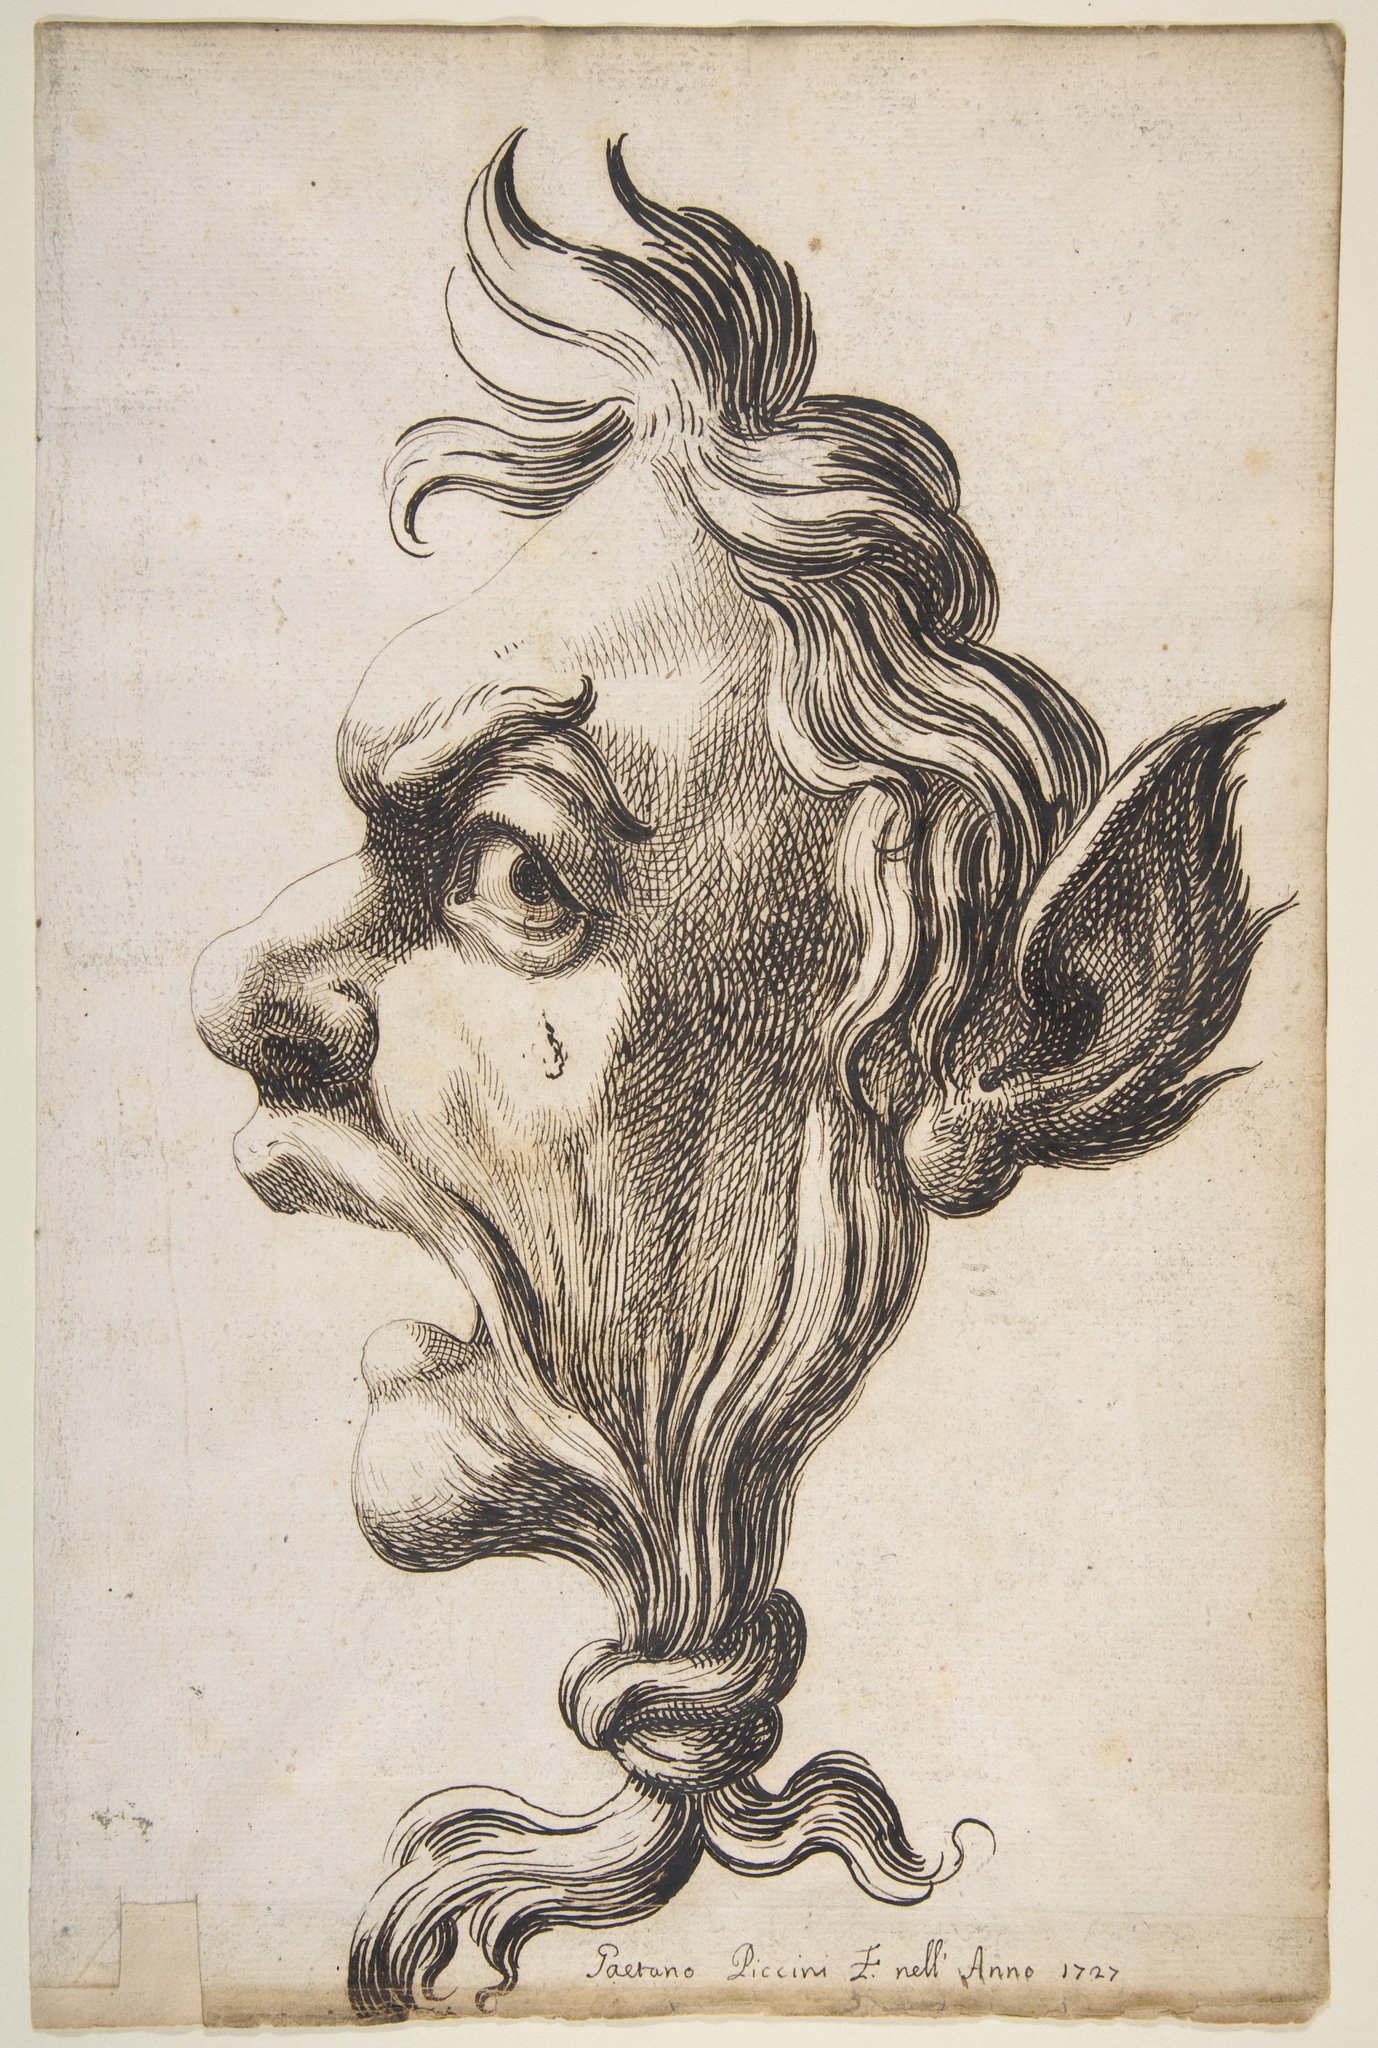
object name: drawing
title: Large Grotesque Head Being Strangled by its Own Hair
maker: gaetano piccini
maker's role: artist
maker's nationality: italian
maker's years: 1710-1730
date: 1727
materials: ink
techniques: pen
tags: heads